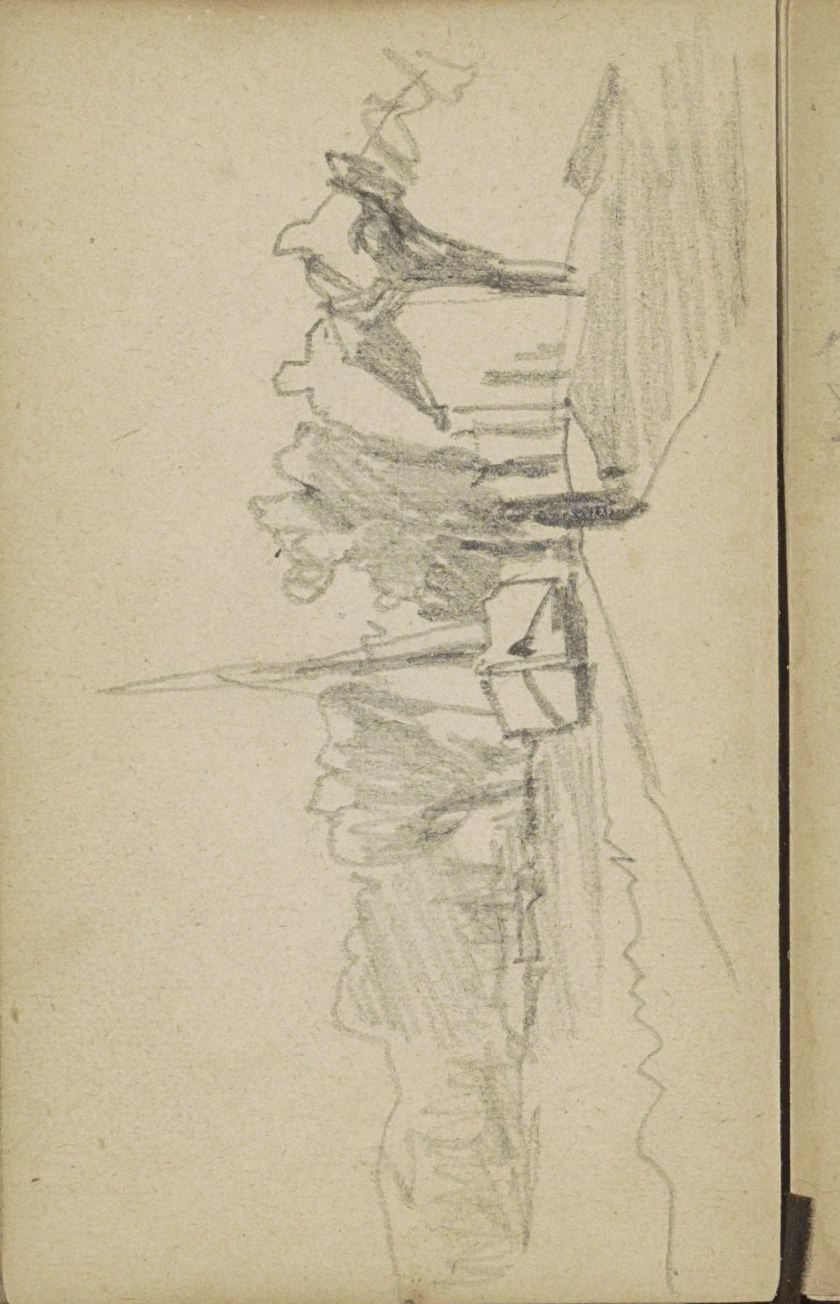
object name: sketchbook leaf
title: Zeilboot op een vaart langs een pad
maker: johan hendrik weissenbruch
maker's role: draughtsman, painter, print maker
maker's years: 1824-1903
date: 1834-1903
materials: paper, pencil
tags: sailing-ship, sailing-boat, road, path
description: Blad 9 verso uit een schetsboek met 32 bladen.